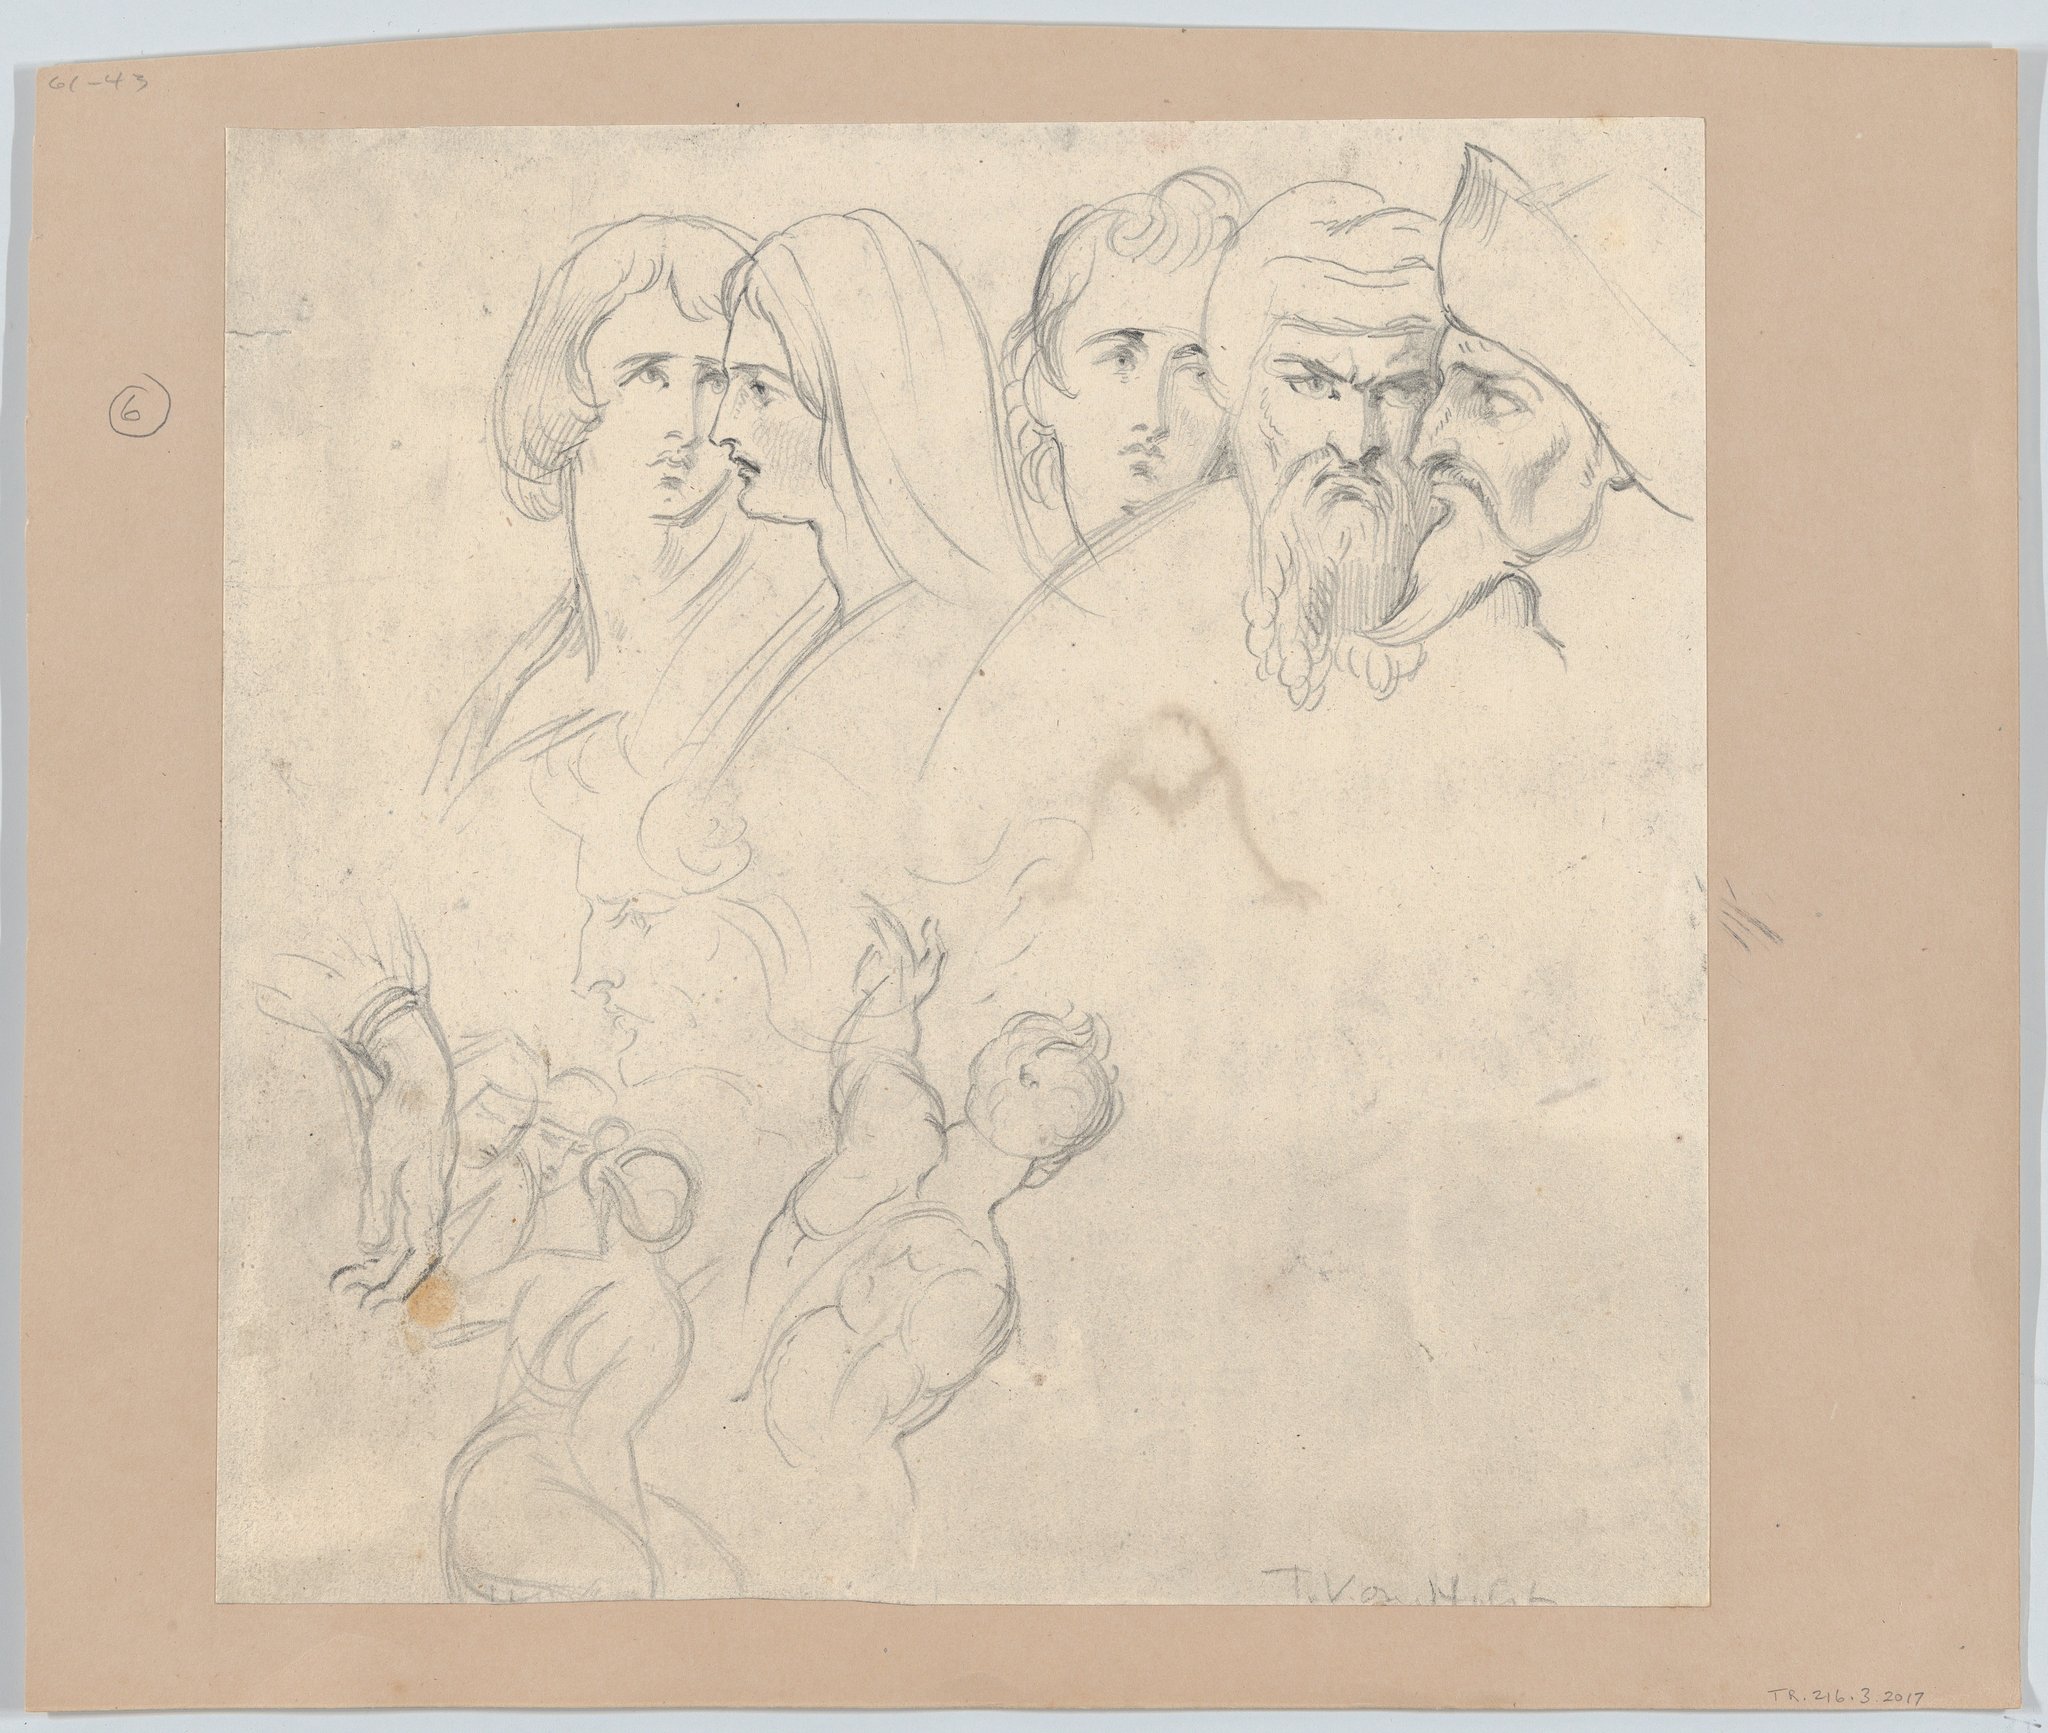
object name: drawing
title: A group of five heads with other studies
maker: theodor richard edward von holst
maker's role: artist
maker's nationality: british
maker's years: 1810-1844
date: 1830-1844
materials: graphite